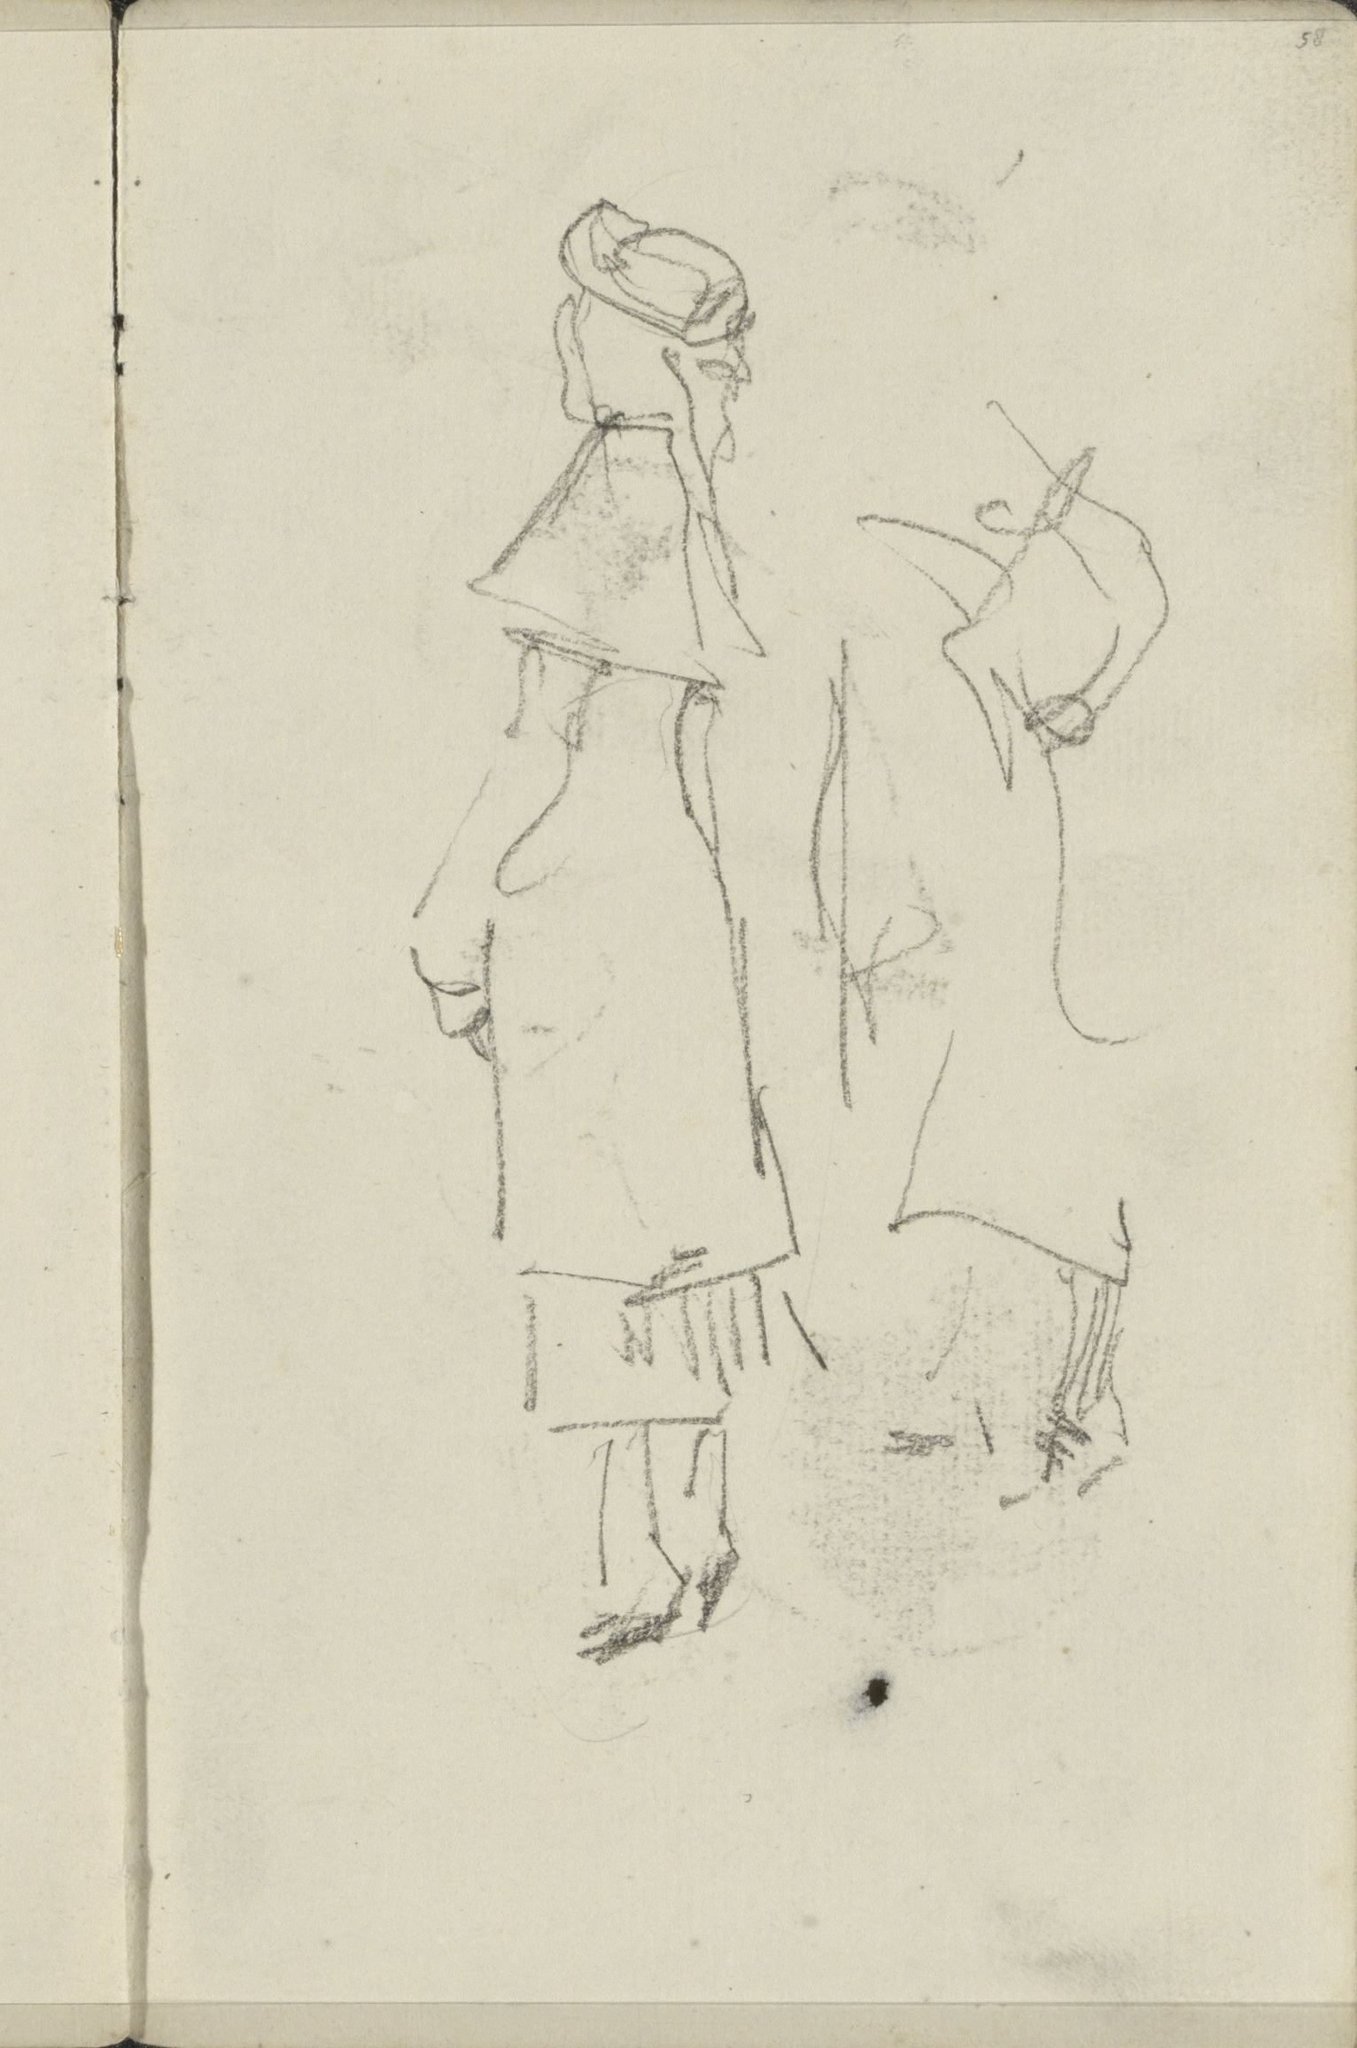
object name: sketchbook leaf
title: Twee studies van een staande vrouw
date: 1882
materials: chalk, paper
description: Pagina 58 uit een schetsboek met 31 bladen vervaardigd te Den Haag en Rotterdam.